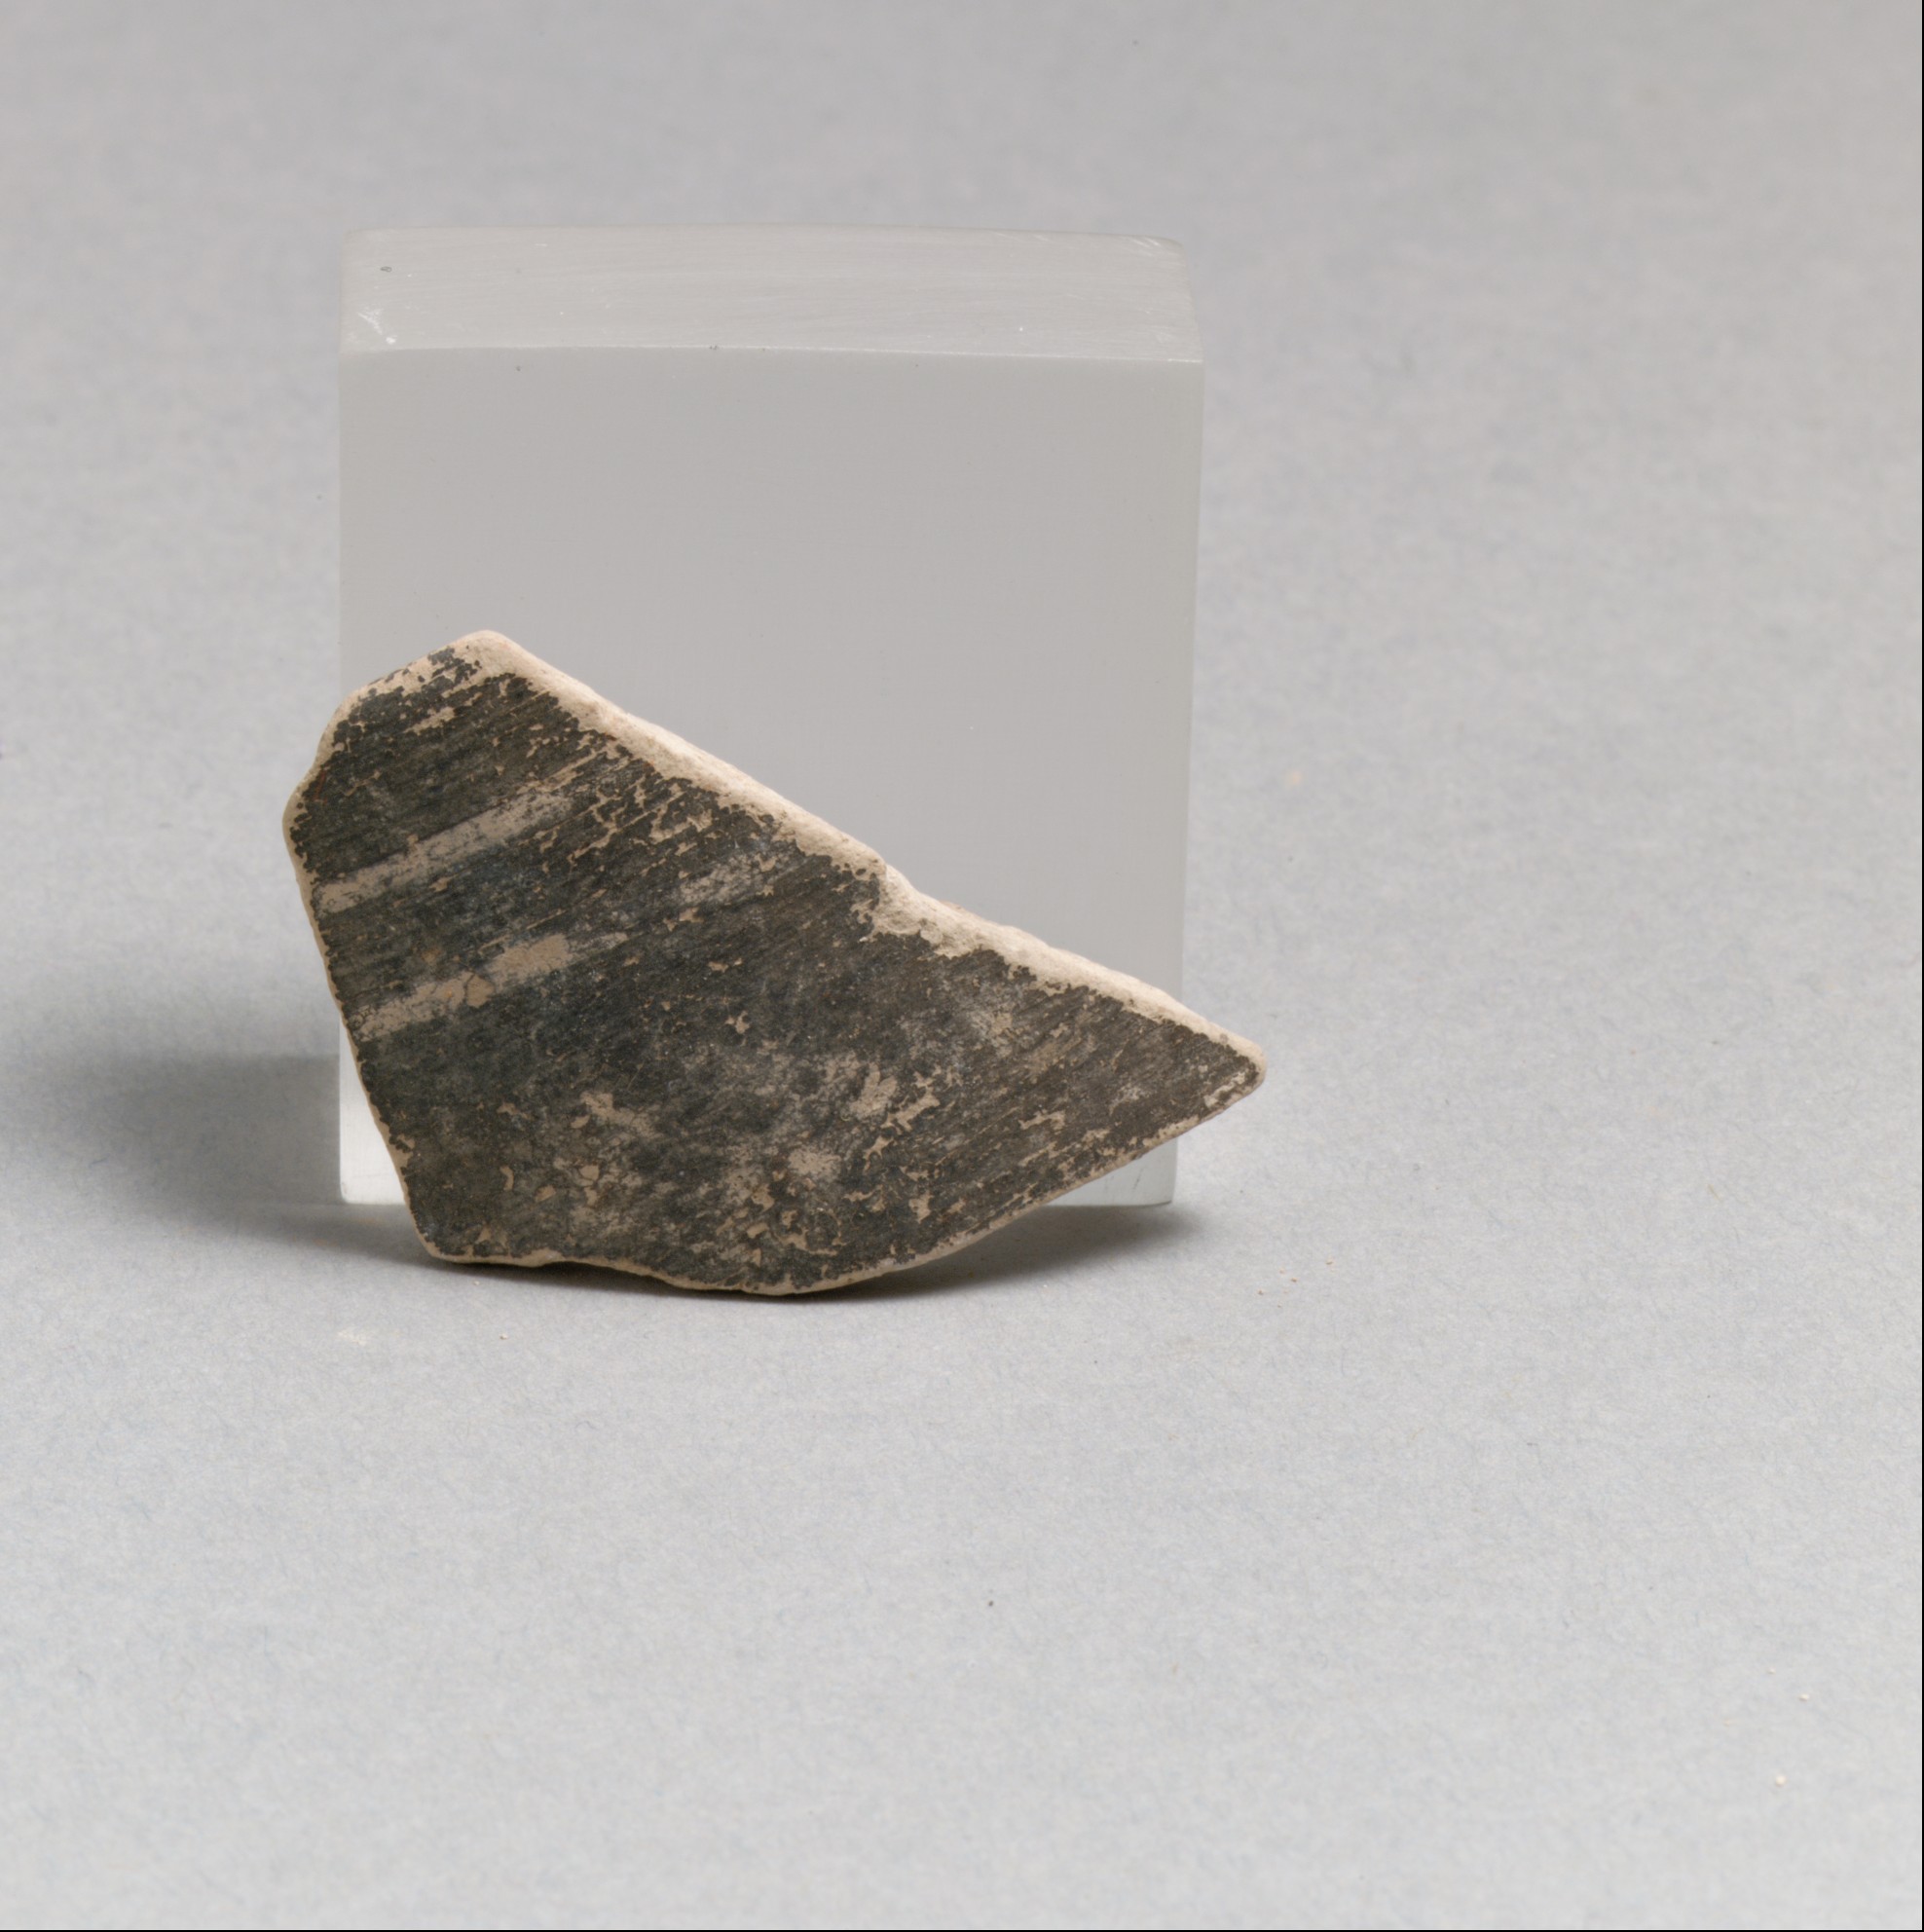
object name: vase fragment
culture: minoan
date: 2600-2000 BCE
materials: terracotta